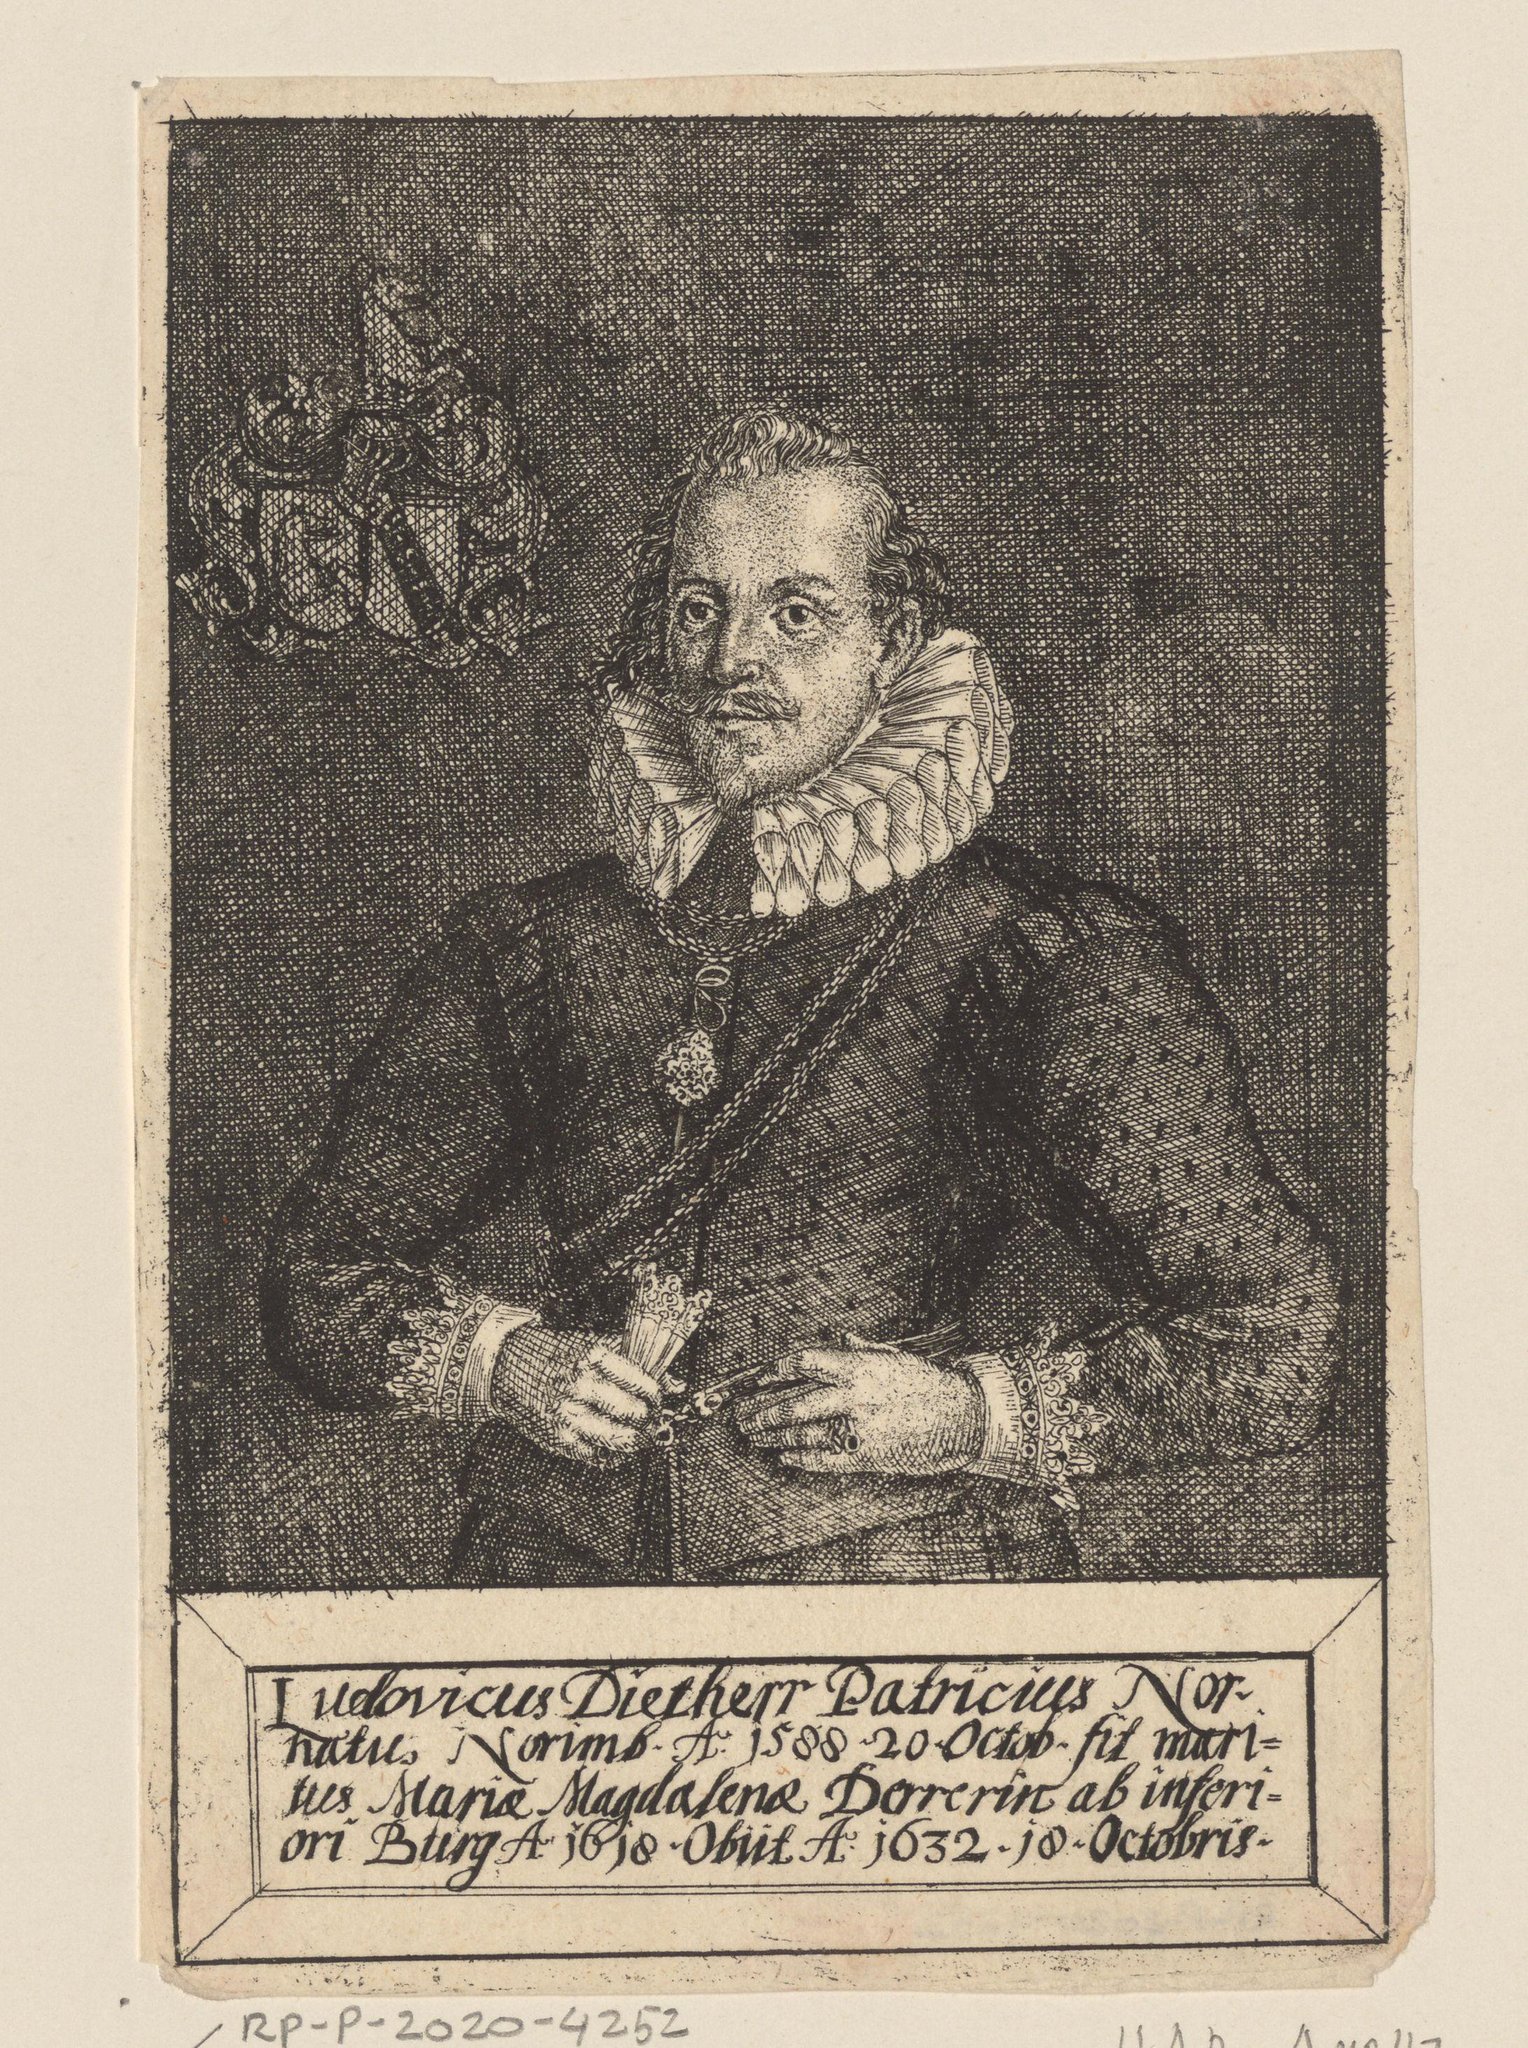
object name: print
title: Portret van Ludwig von Dietherr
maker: martin heinrich omeis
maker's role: print maker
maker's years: 1650-1703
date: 1660-1703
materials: paper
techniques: etching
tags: historical persons, armorial bearing, heraldry